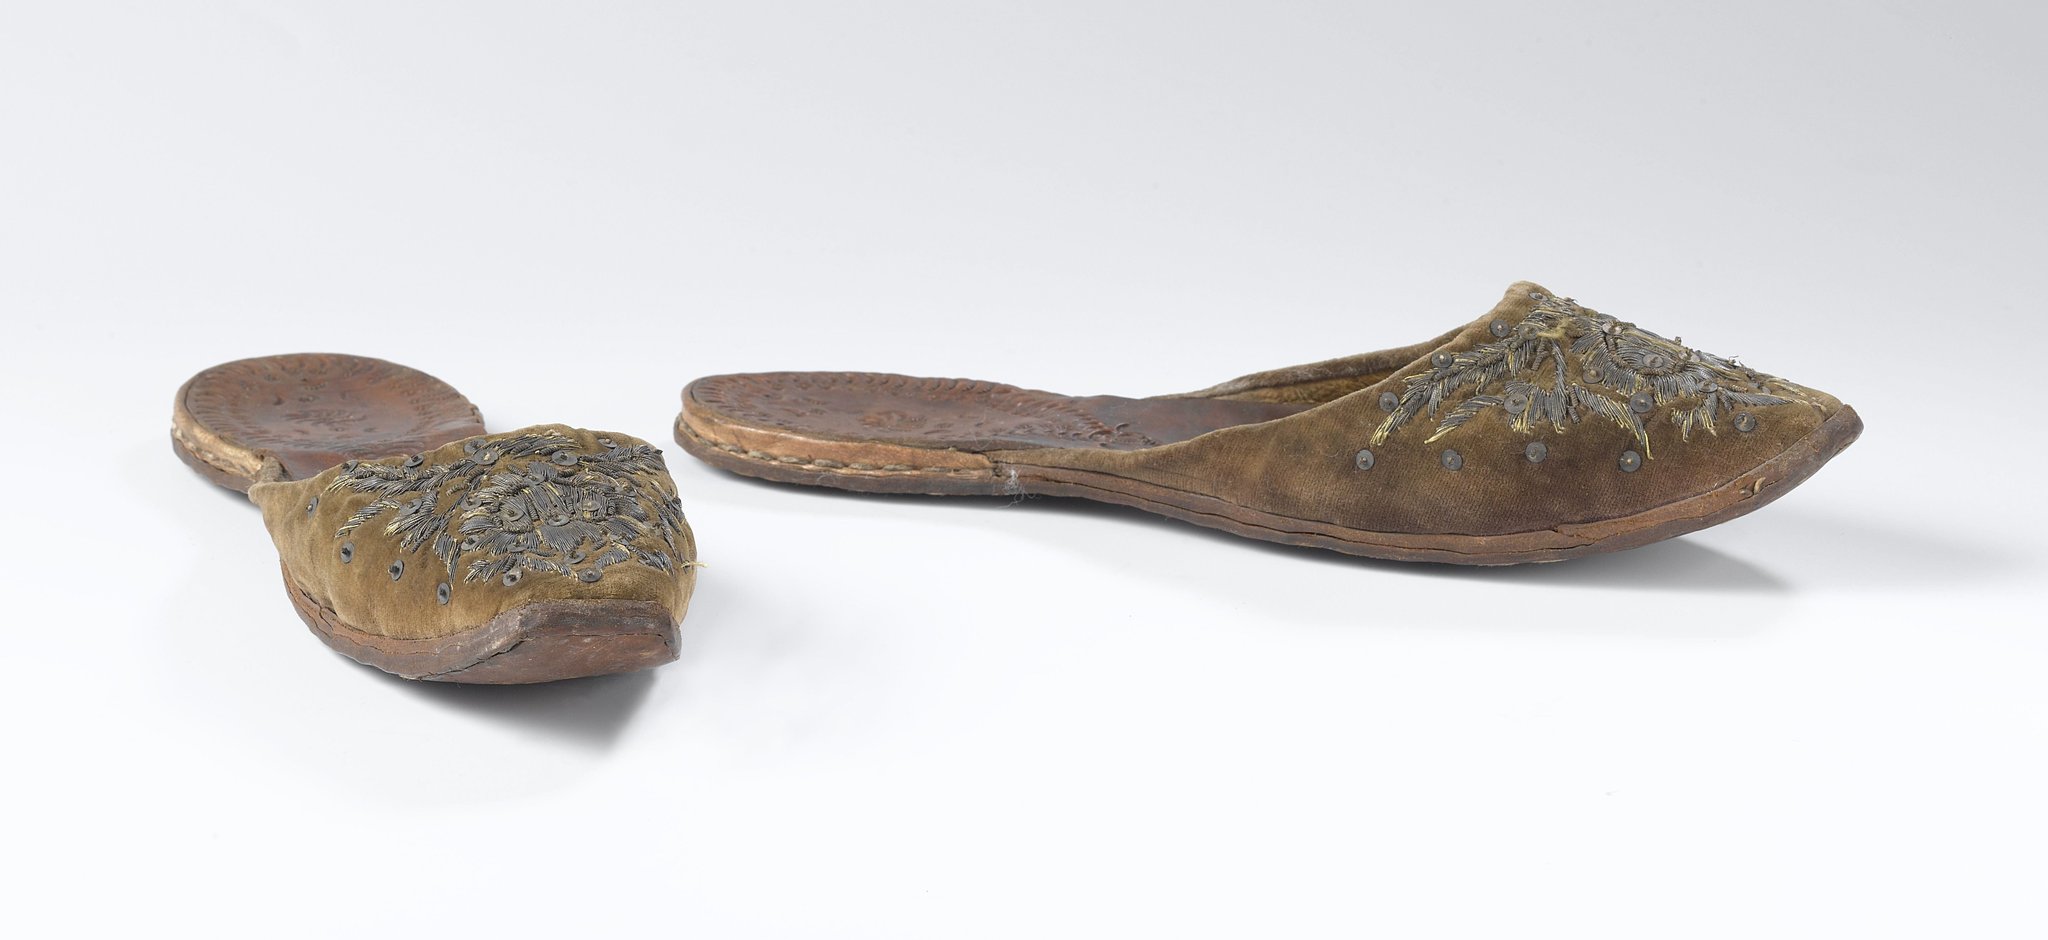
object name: mule shoe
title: Damesmuil van karmijnrood fluweel, versierd met zilverdraad en lovertjes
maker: Anonymous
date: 1825-1875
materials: leather, thread, velvet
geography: western europe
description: Damesmuil, van karmijnrood fluweel, versierd met zilverdraad en lovertjes. Model: zonder hakken en met smal toelopende voorvoet, eindigend in een vierkante neus. Gevoerd met leer met geponste versiering op de plaats van de hiel.